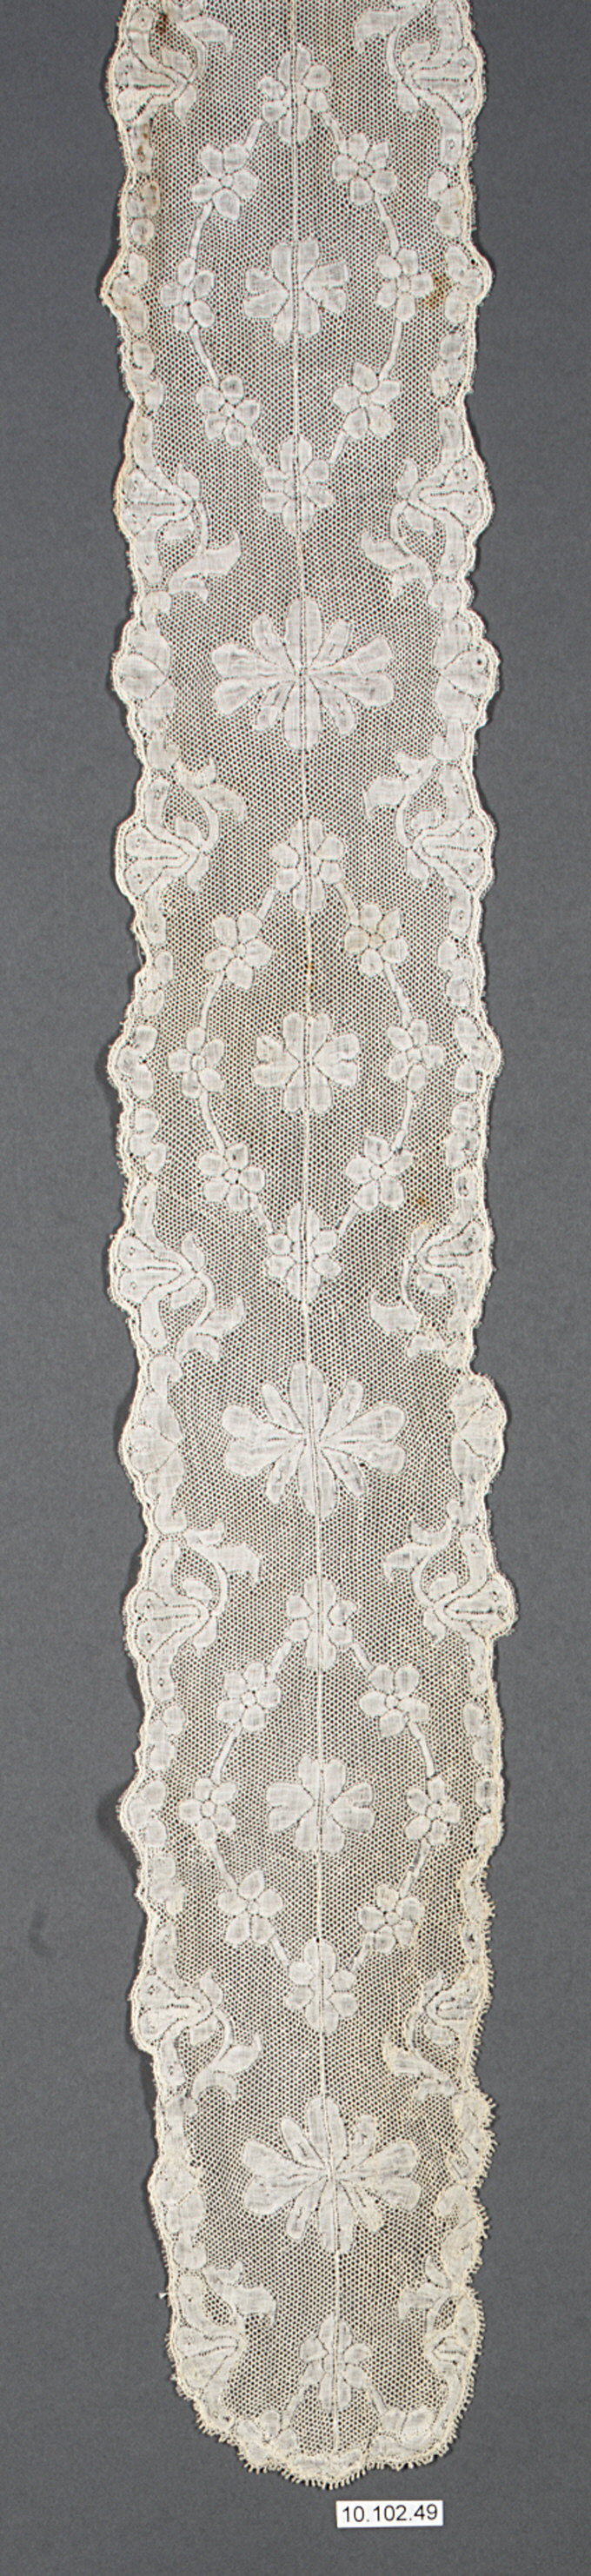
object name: barbe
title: Barbe (one of three pieces)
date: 1701-1800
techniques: lace